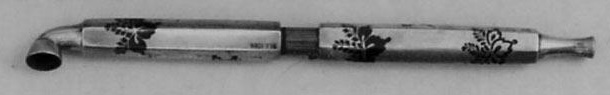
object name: tobacco pipe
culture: japanese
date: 1801-1900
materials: silver